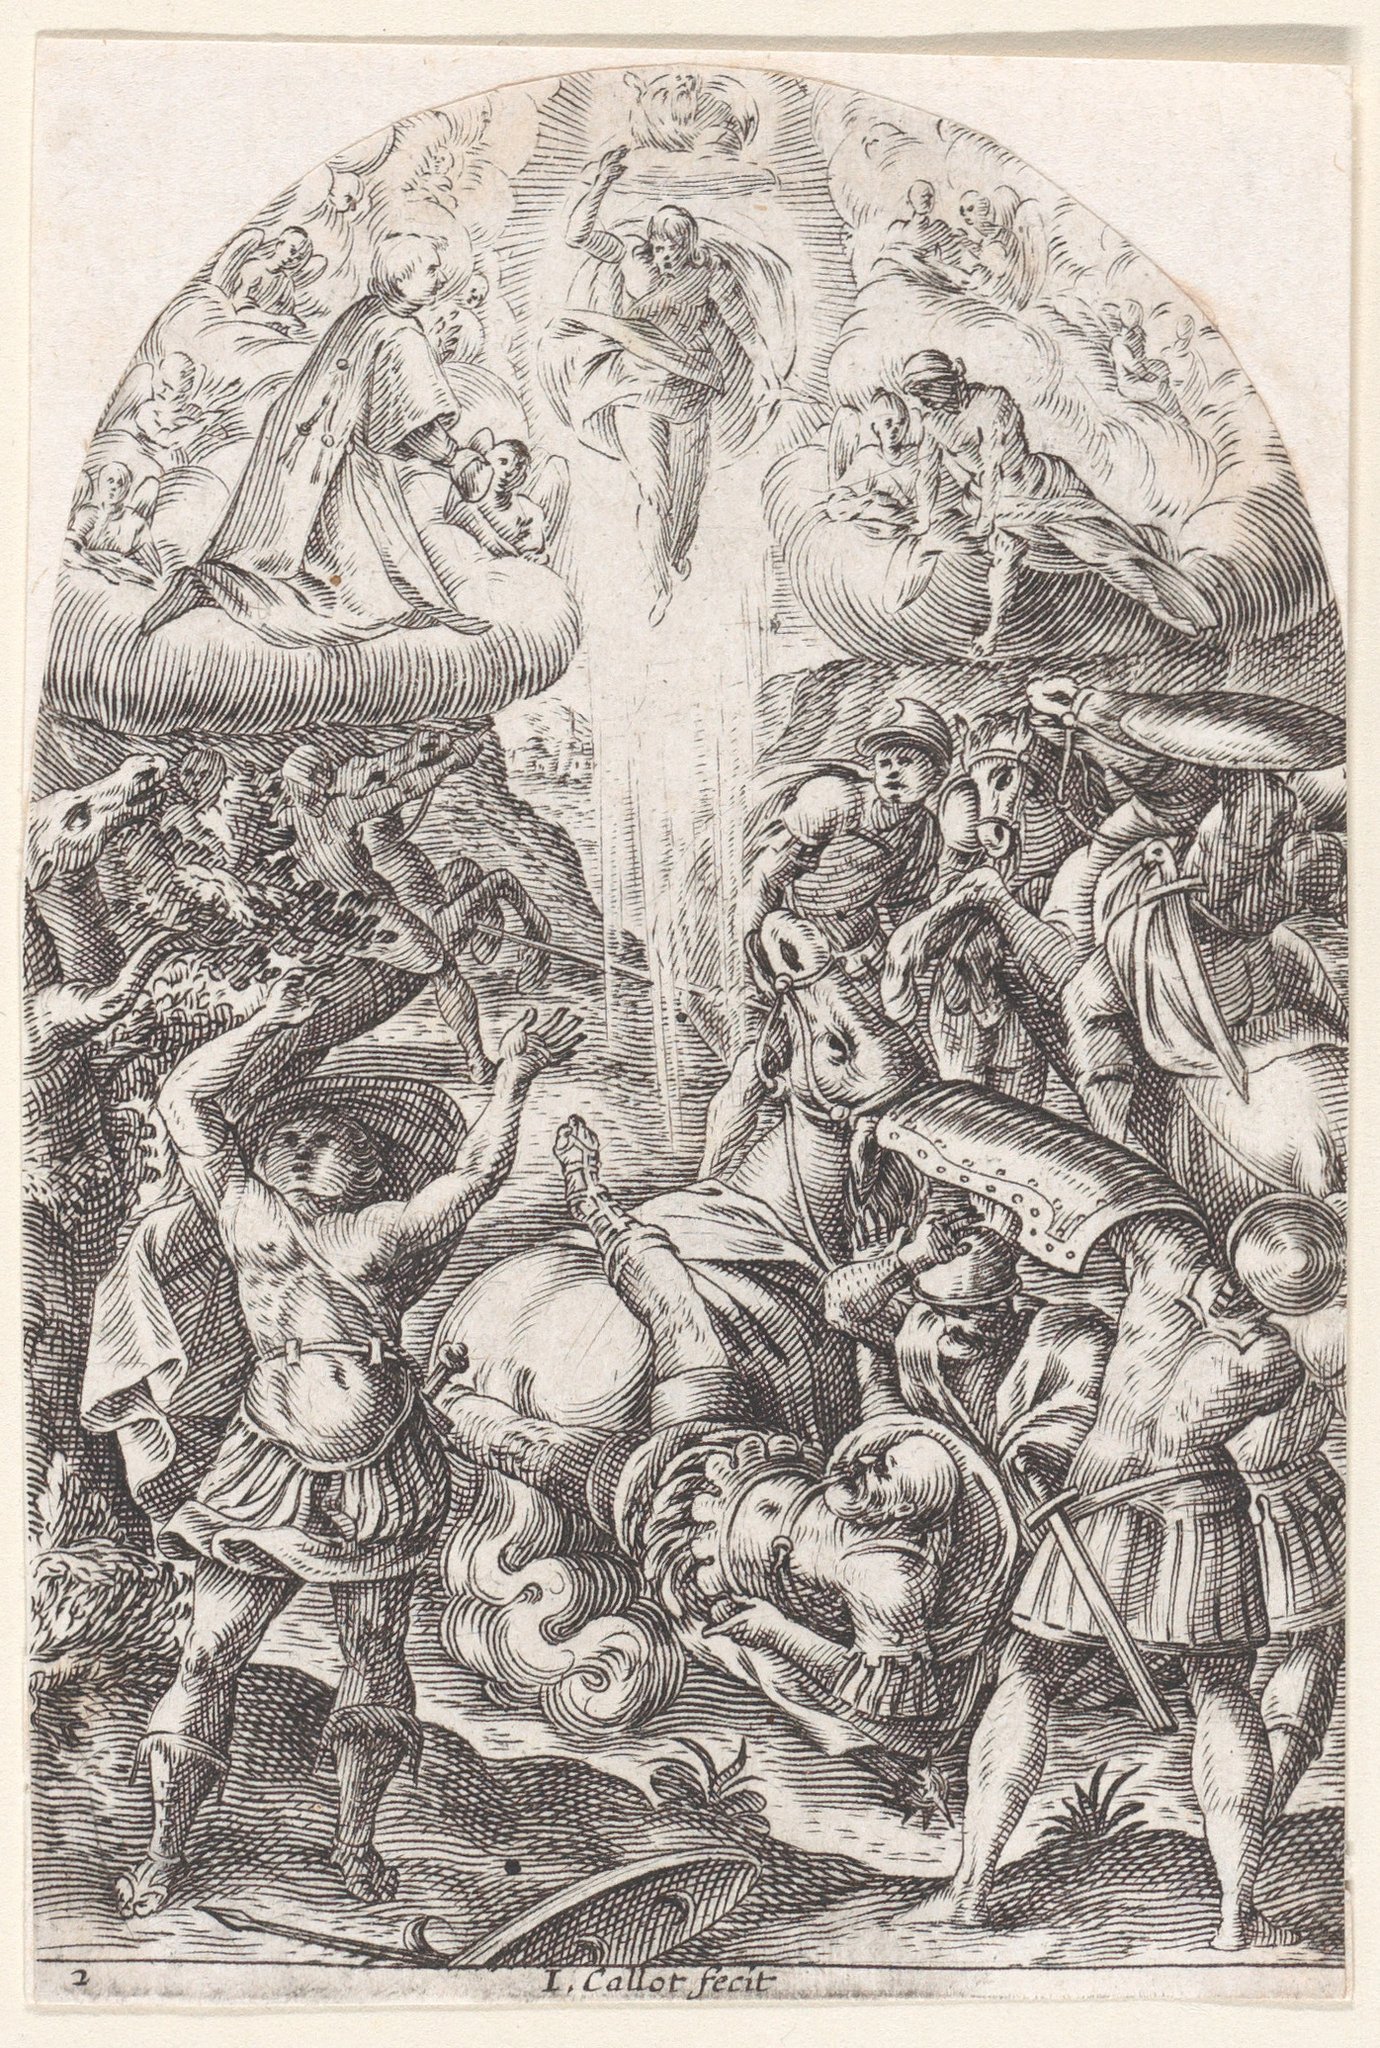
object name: print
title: The Conversion of St. Paul, plate 2 from "Les Tableaux de Rome, Les Eglises Jubilaires" (The Paintings of Rome, The Churches Jubilee)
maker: jacques callot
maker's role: artist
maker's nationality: french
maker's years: 1592-1635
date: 1607-1611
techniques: engraving